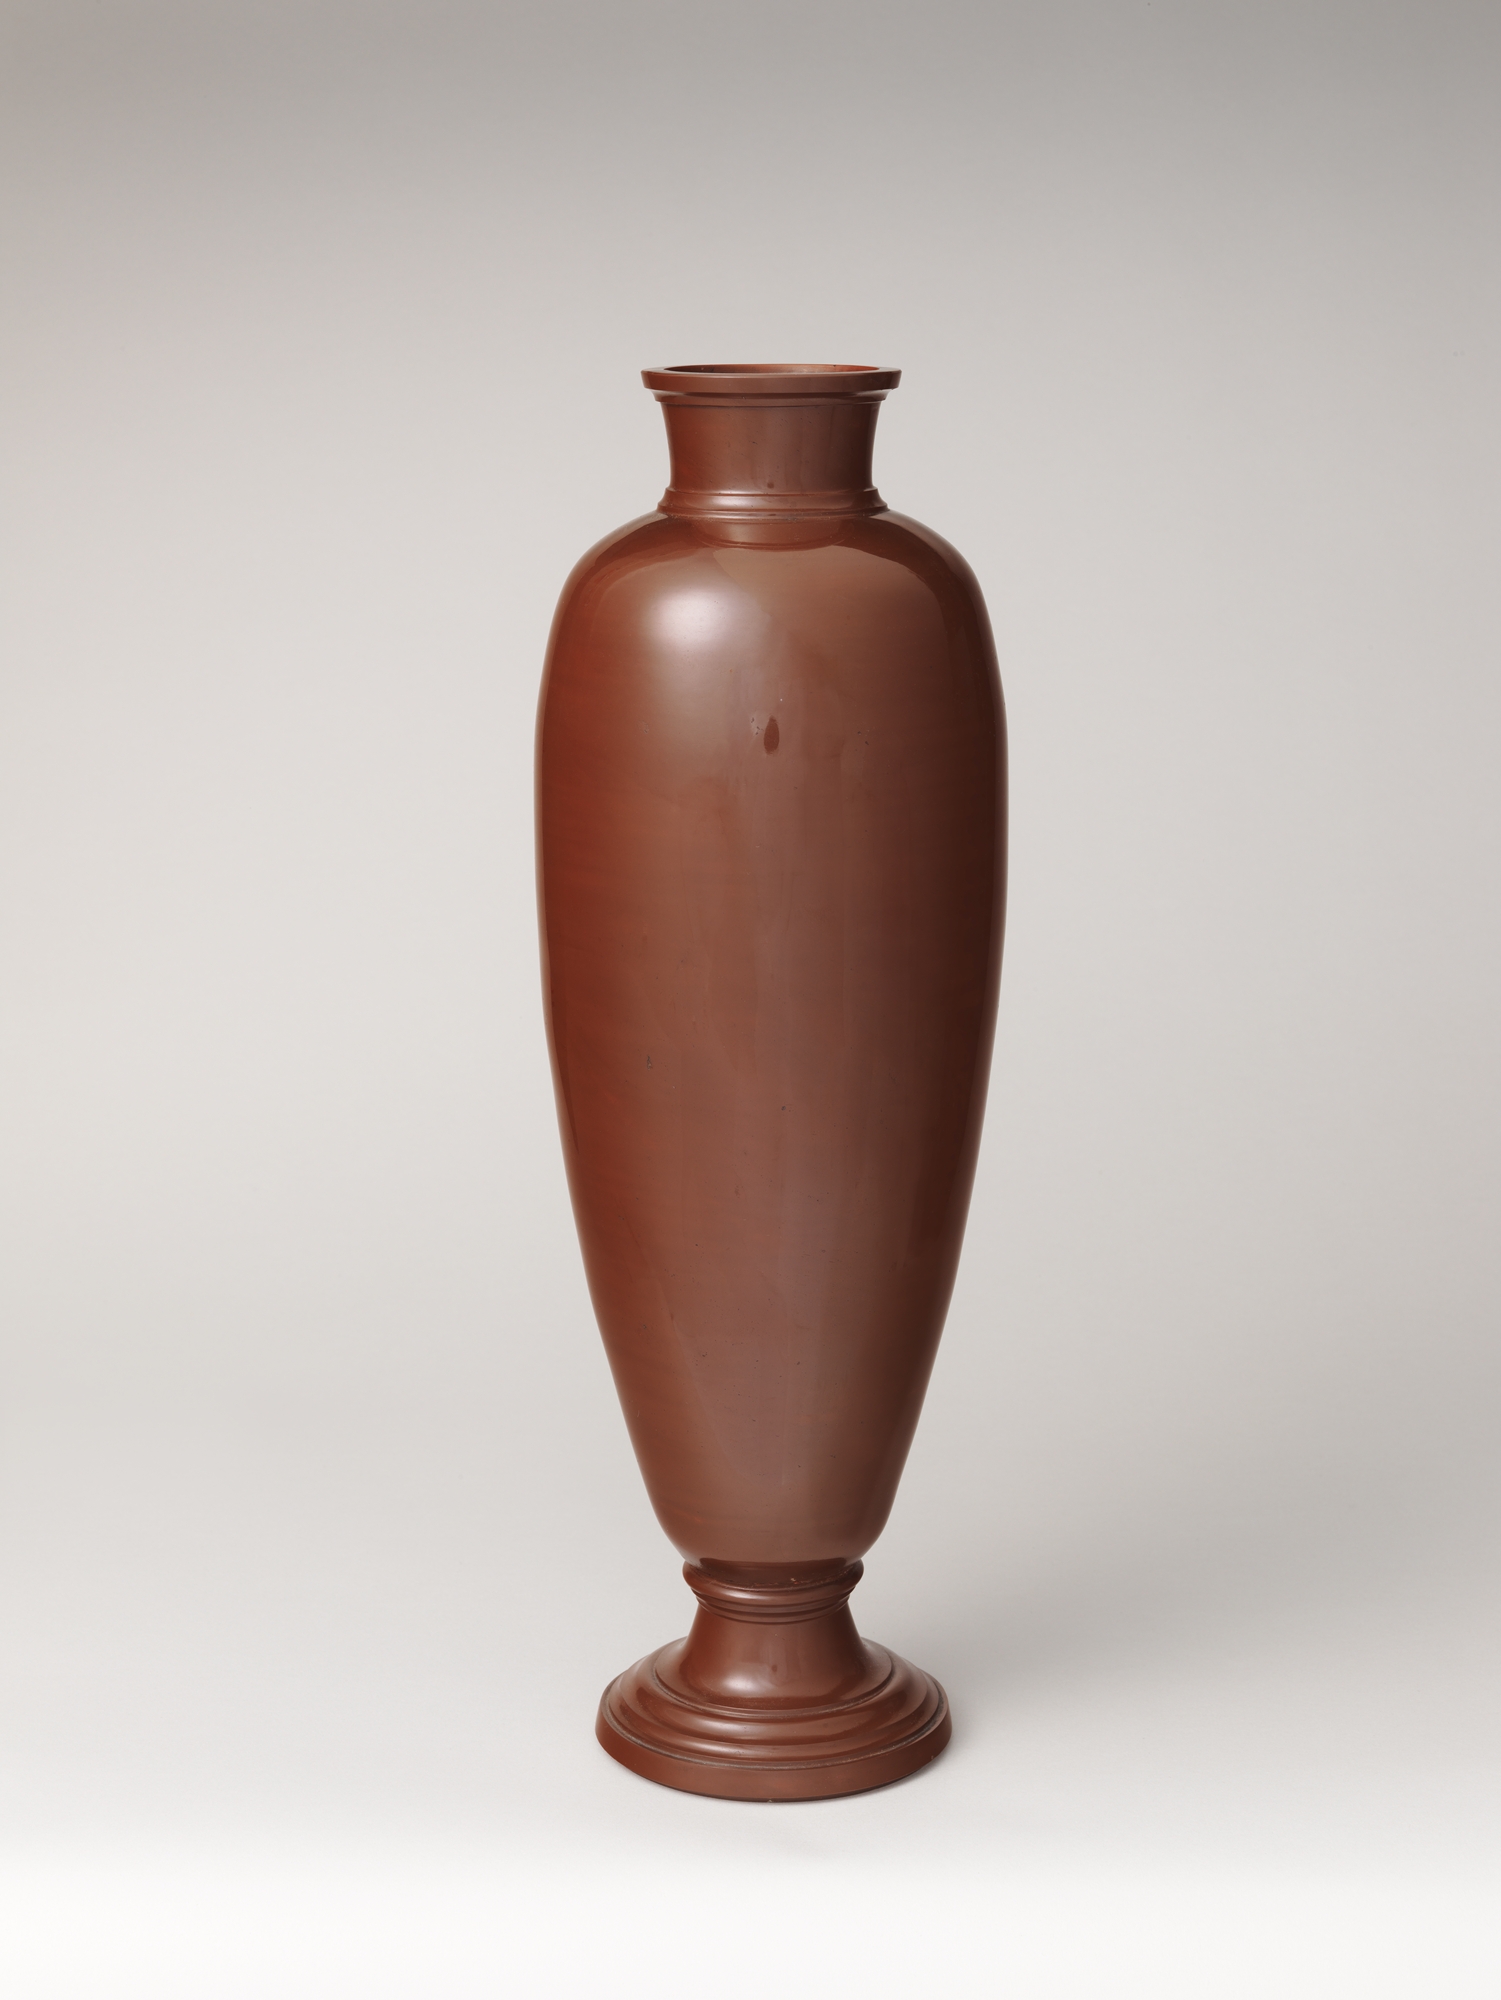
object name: vase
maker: meissen manufactory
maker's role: manufactory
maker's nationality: german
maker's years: 1710-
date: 1710-1713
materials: stoneware